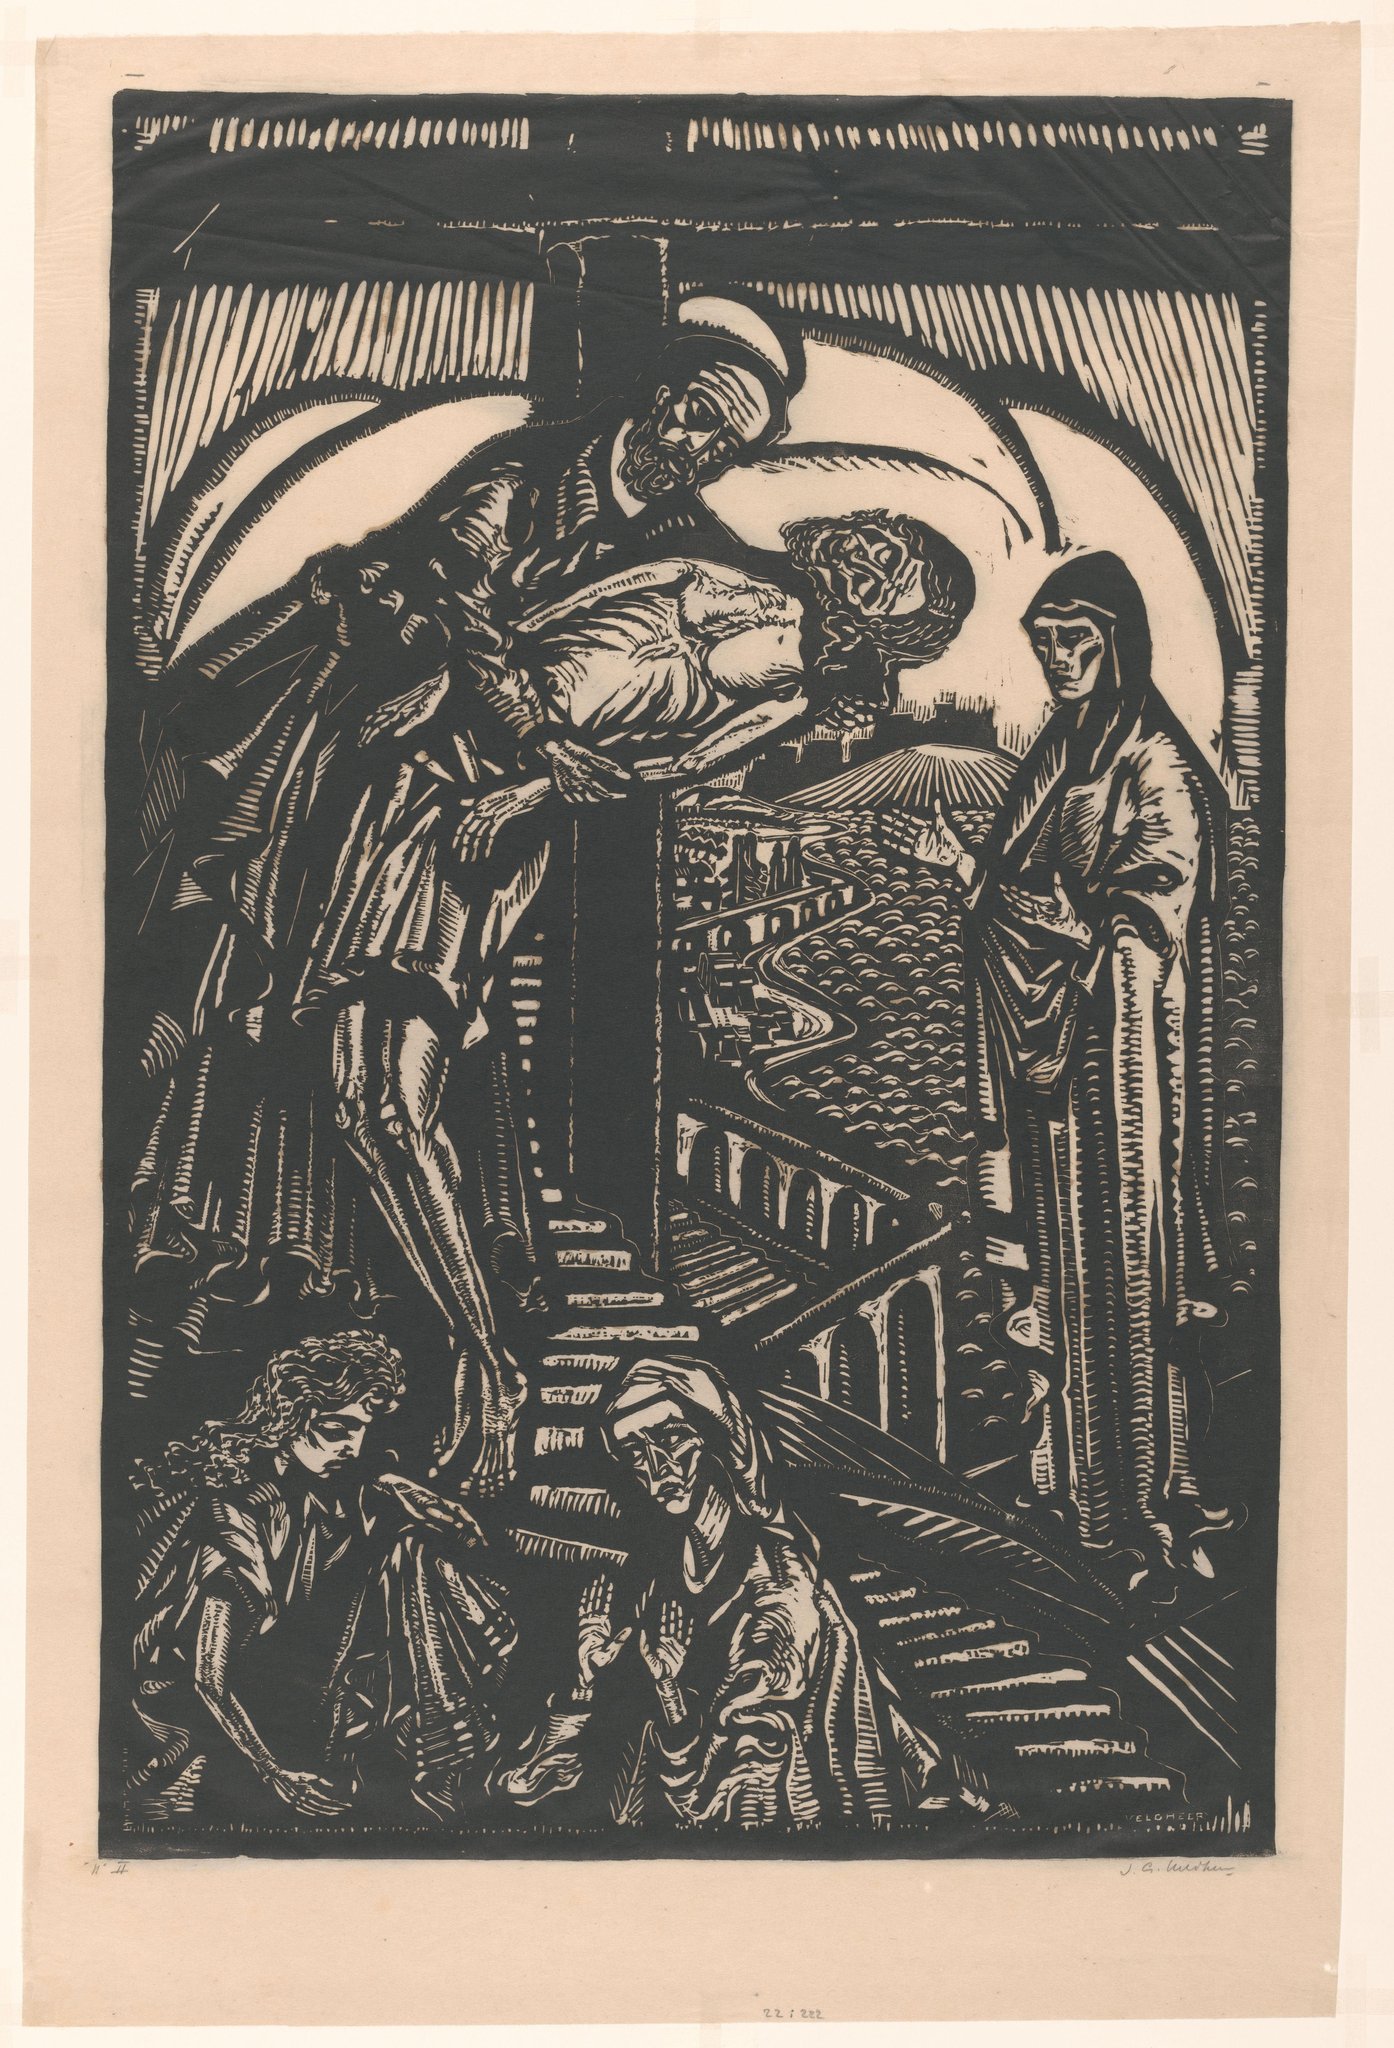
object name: print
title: Kruisafname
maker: jacobus gerardus veldheer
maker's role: draughtsman, print maker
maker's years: 1866-1954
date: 1881-1922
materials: paper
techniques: woodcut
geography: netherlands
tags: descent from the cross: christ is taken down from the cross, usually by nicodemus and joseph of arimathaea who are standing on the ladders (both arms of christ detached)